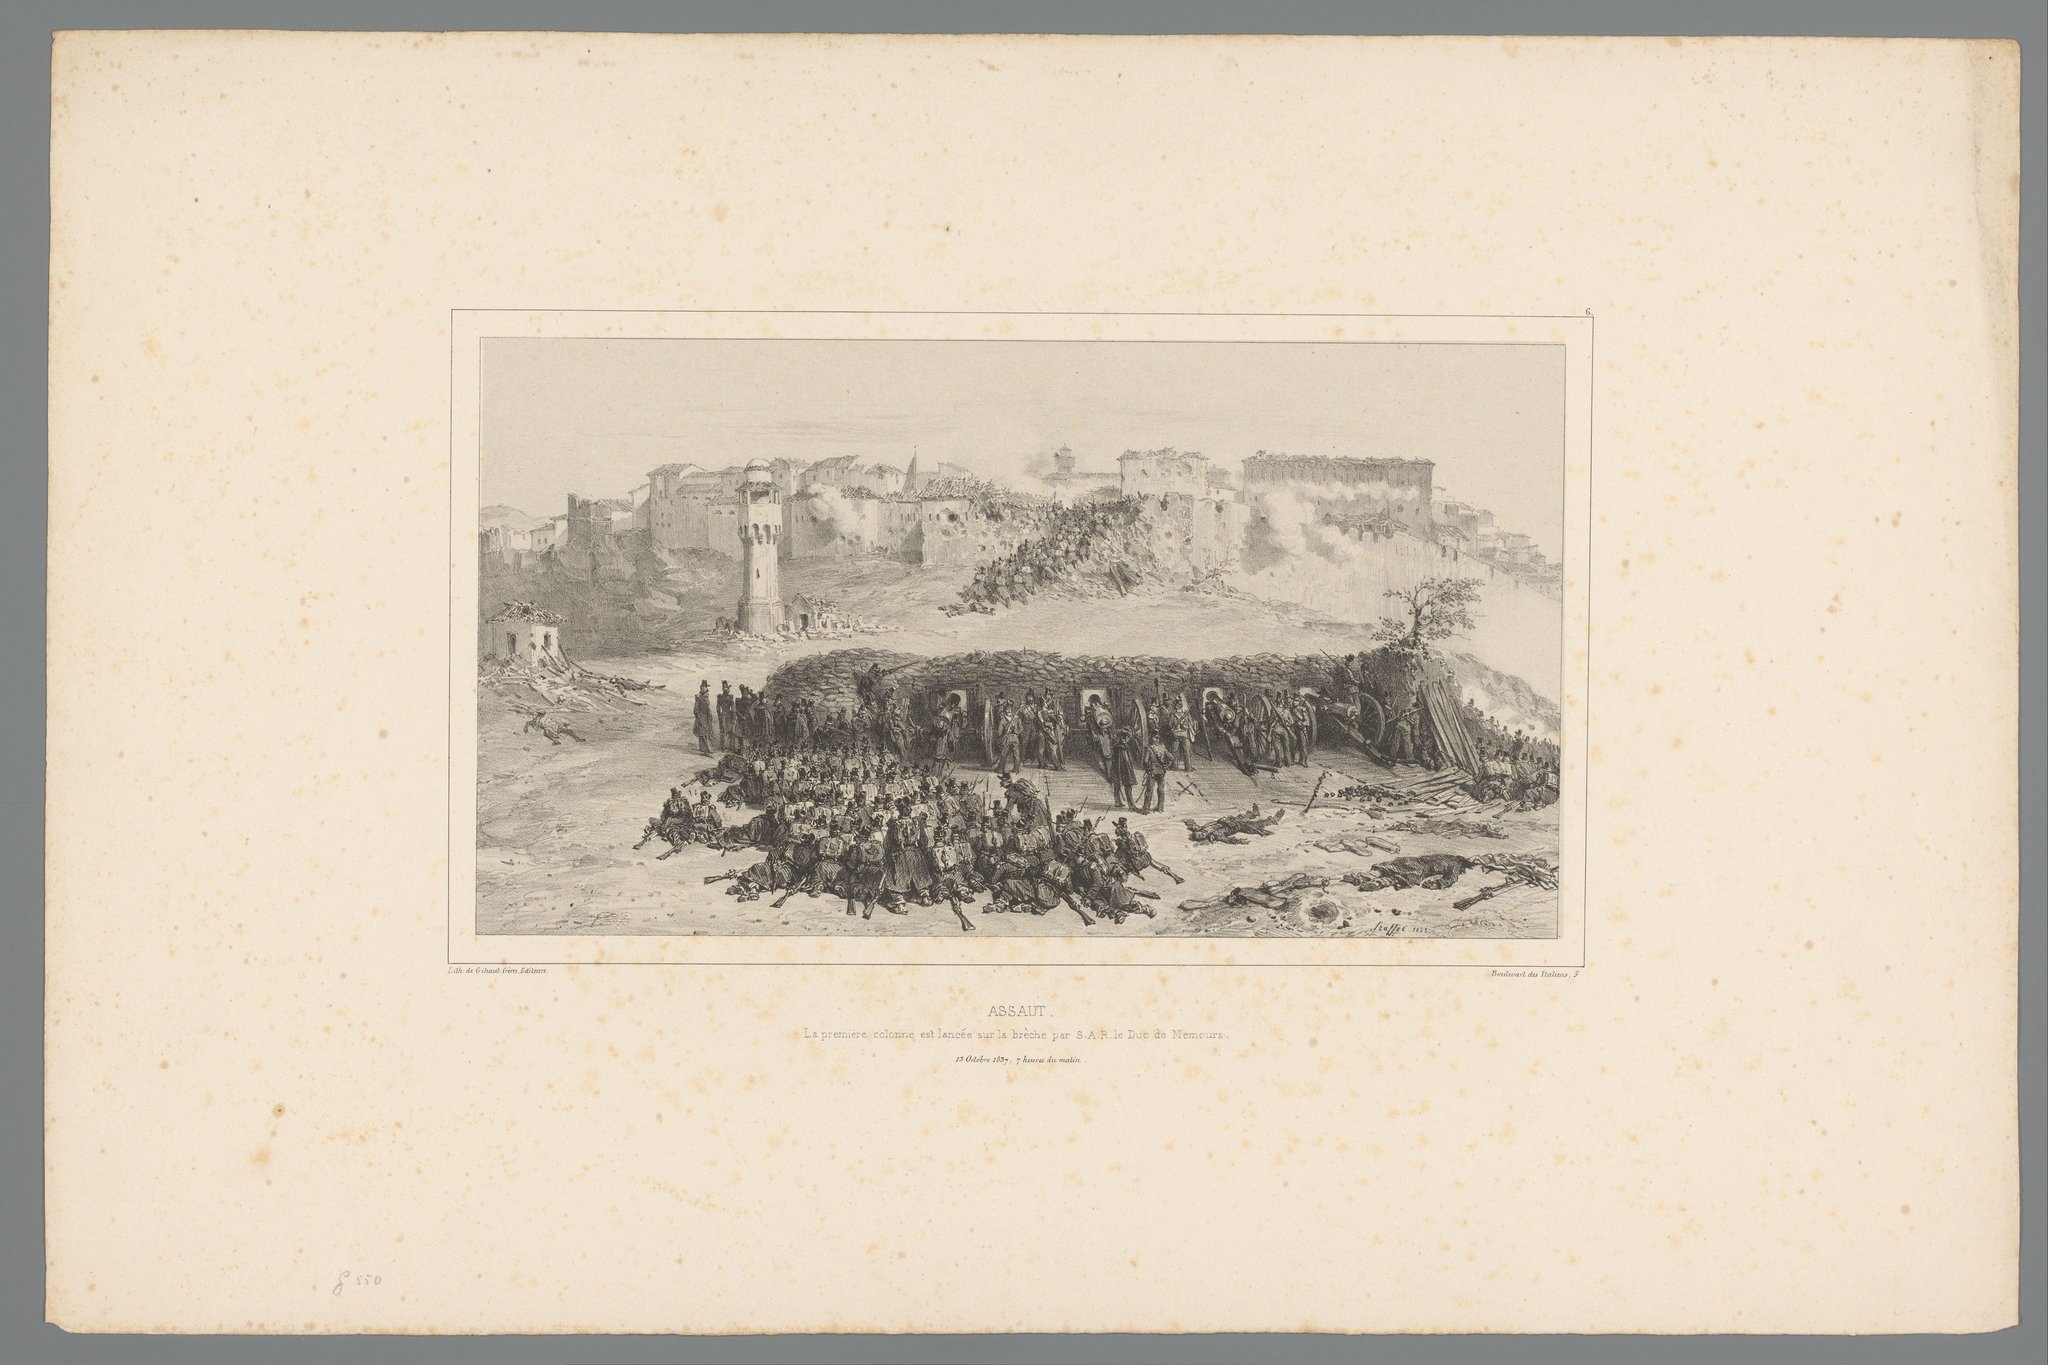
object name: print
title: Assaut (...) 13 octobre 1837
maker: denis auguste marie raffet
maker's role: draughtsman, print maker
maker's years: 1804-1860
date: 1838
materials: paper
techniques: lithograph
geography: paris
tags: firearms: cannon, (military) attack, the soldier; the soldier's life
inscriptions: collector's mark: Lugt 964